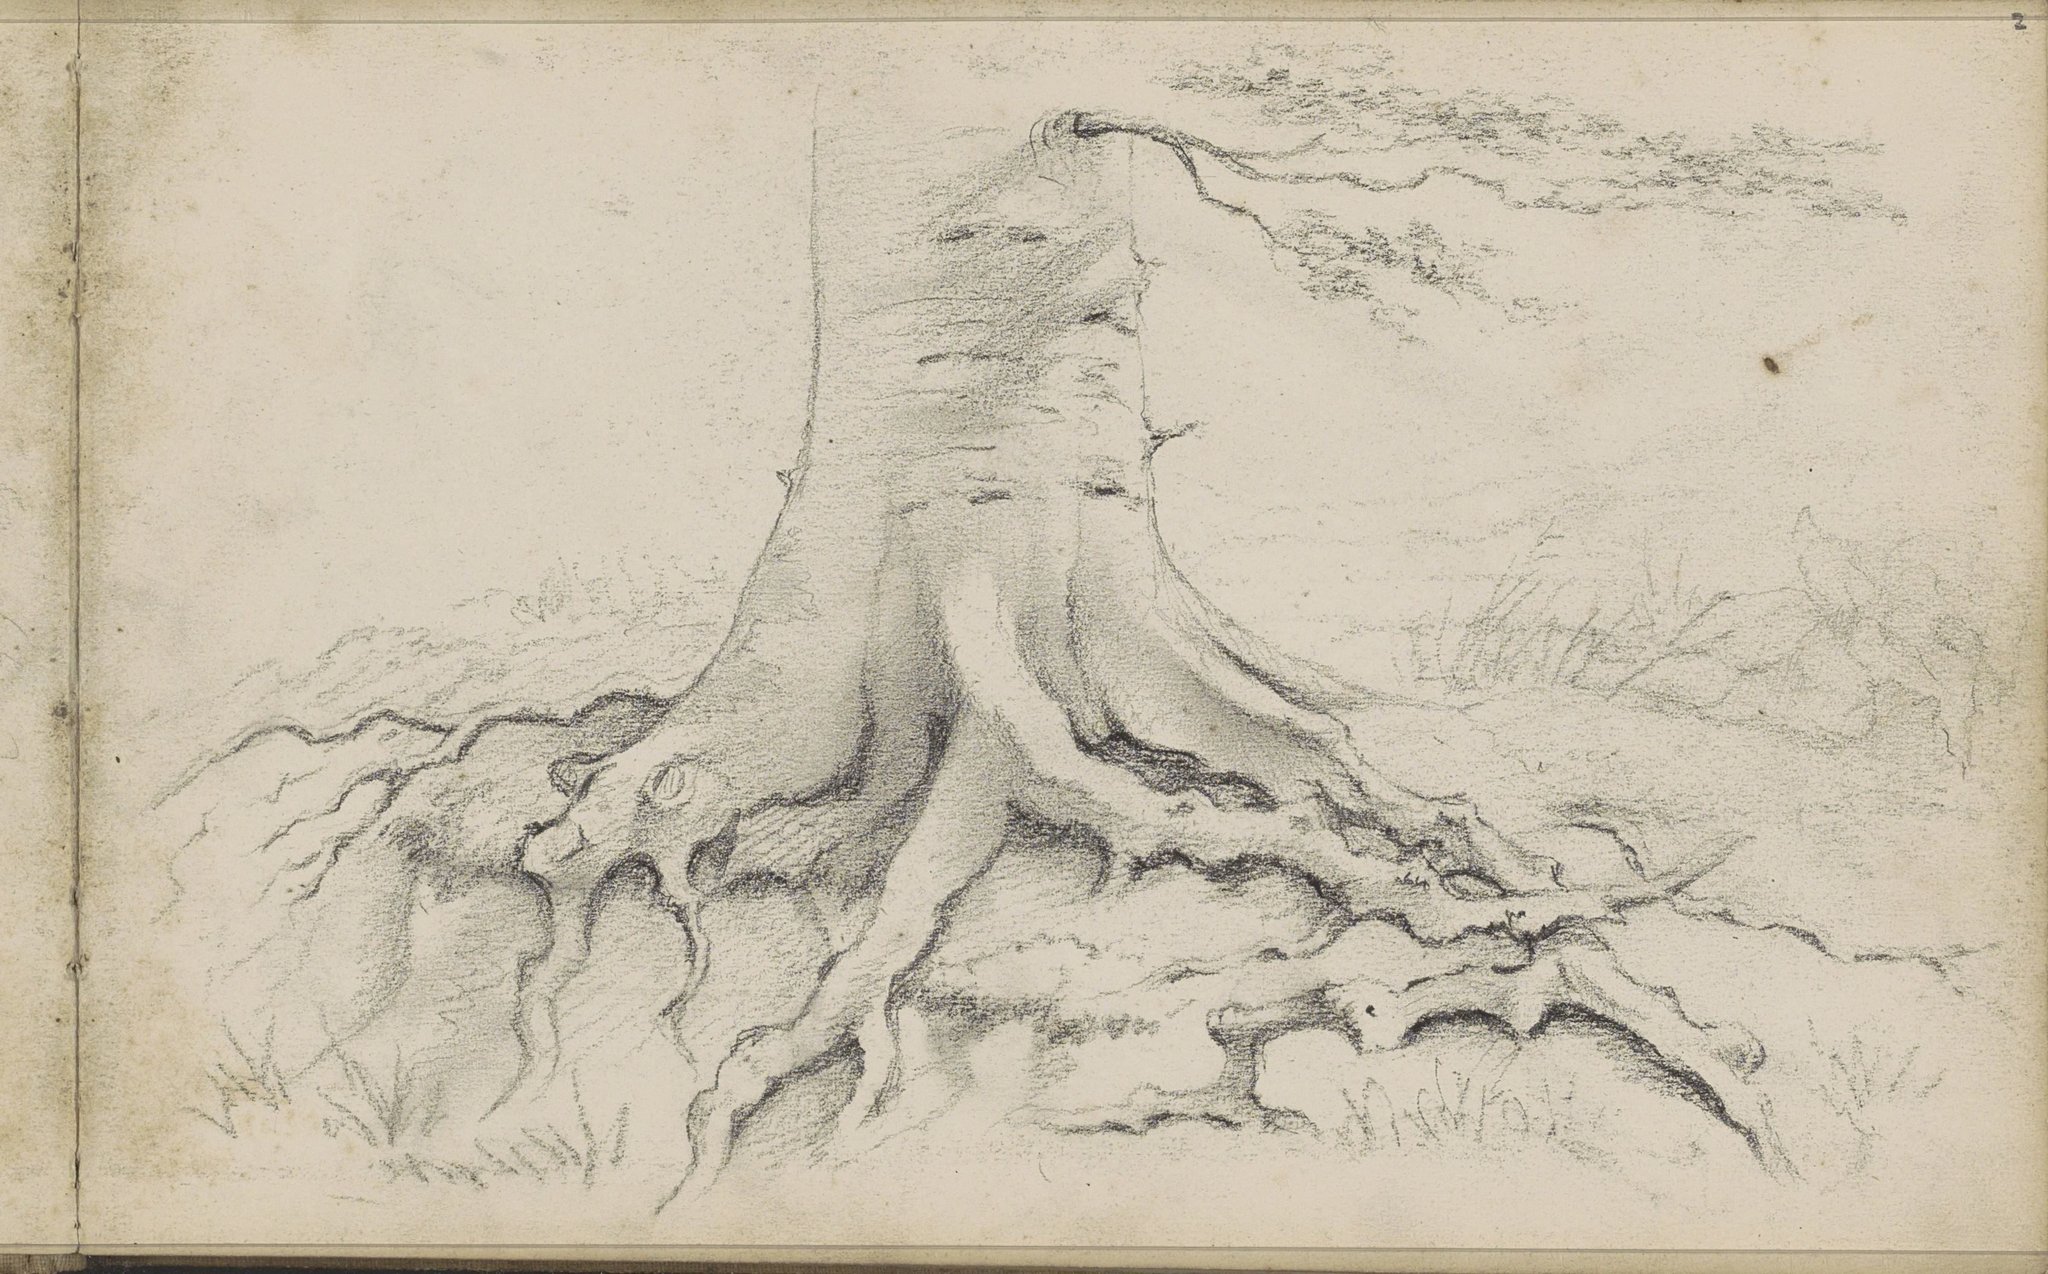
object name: sketchbook leaf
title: Boomwortels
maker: willem cornelis rip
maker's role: draughtsman, painter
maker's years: 1856-1922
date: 1874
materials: paper, pencil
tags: trees (+ root, tuber)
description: Blad 2 recto uit een schetsboek met 47 bladen.